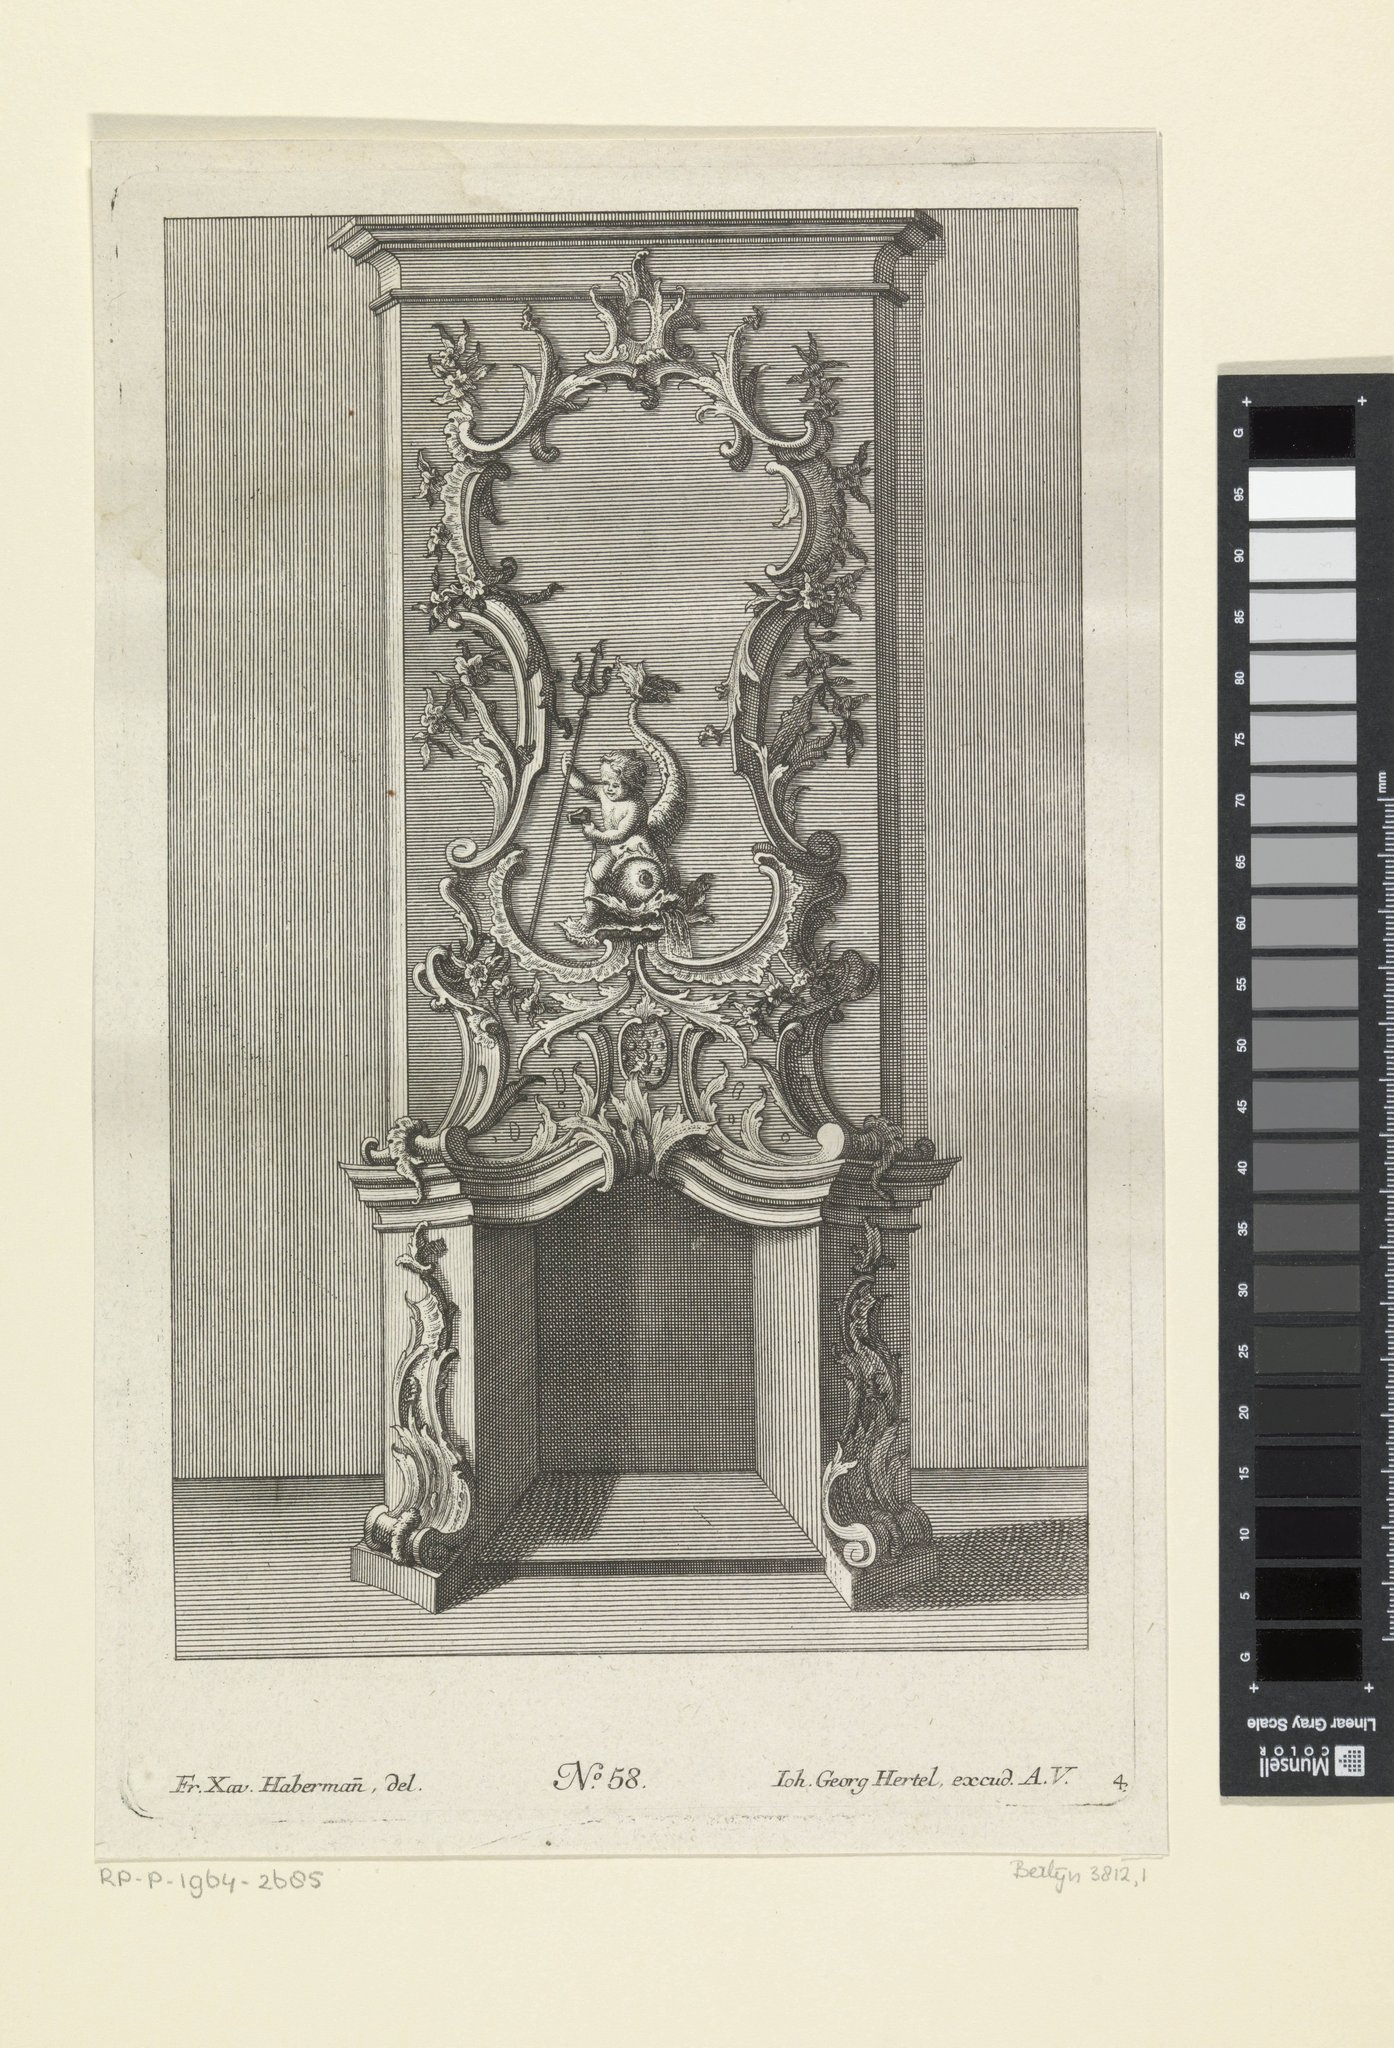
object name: ornament print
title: Schouwen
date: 1731-1775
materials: paper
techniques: engraving, etching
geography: augsburg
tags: rocaille ornament, burning as process, cupids: 'amores', 'amoretti', 'putti'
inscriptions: collector's mark: Lugt 2760, collector's mark: Lugt 2228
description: Rocaille schouw met putto met een drietand op een zeewezen. Uitgeversnummer 58.